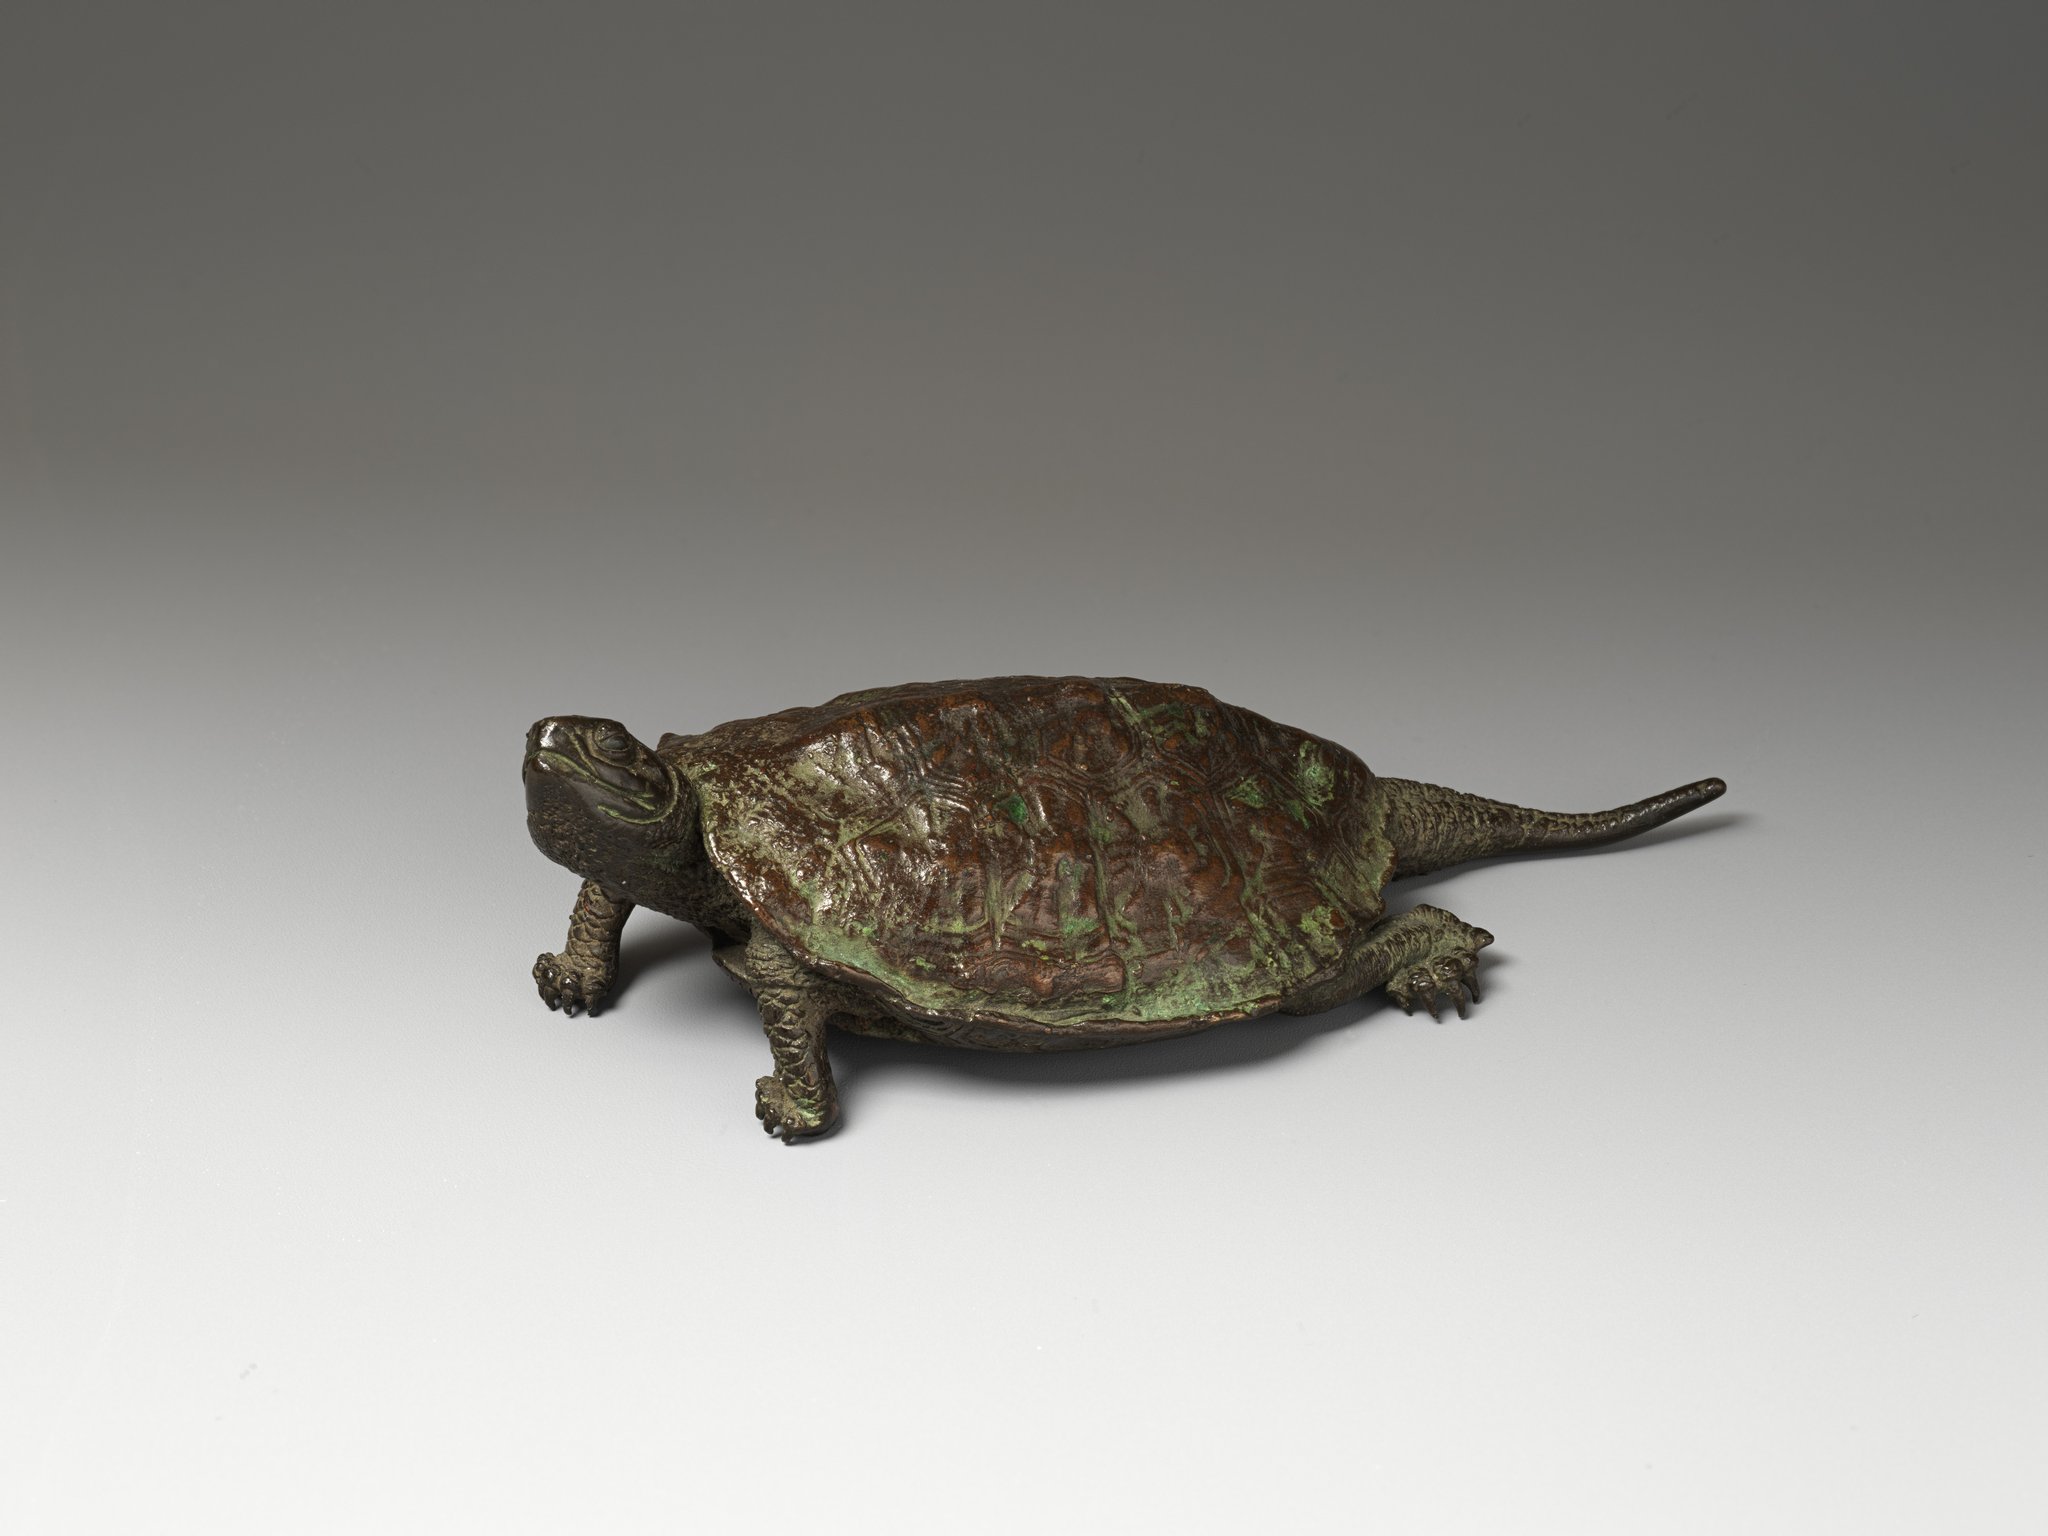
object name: ornament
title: Turtle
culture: japanese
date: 1851-1900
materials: copper alloy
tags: turtles